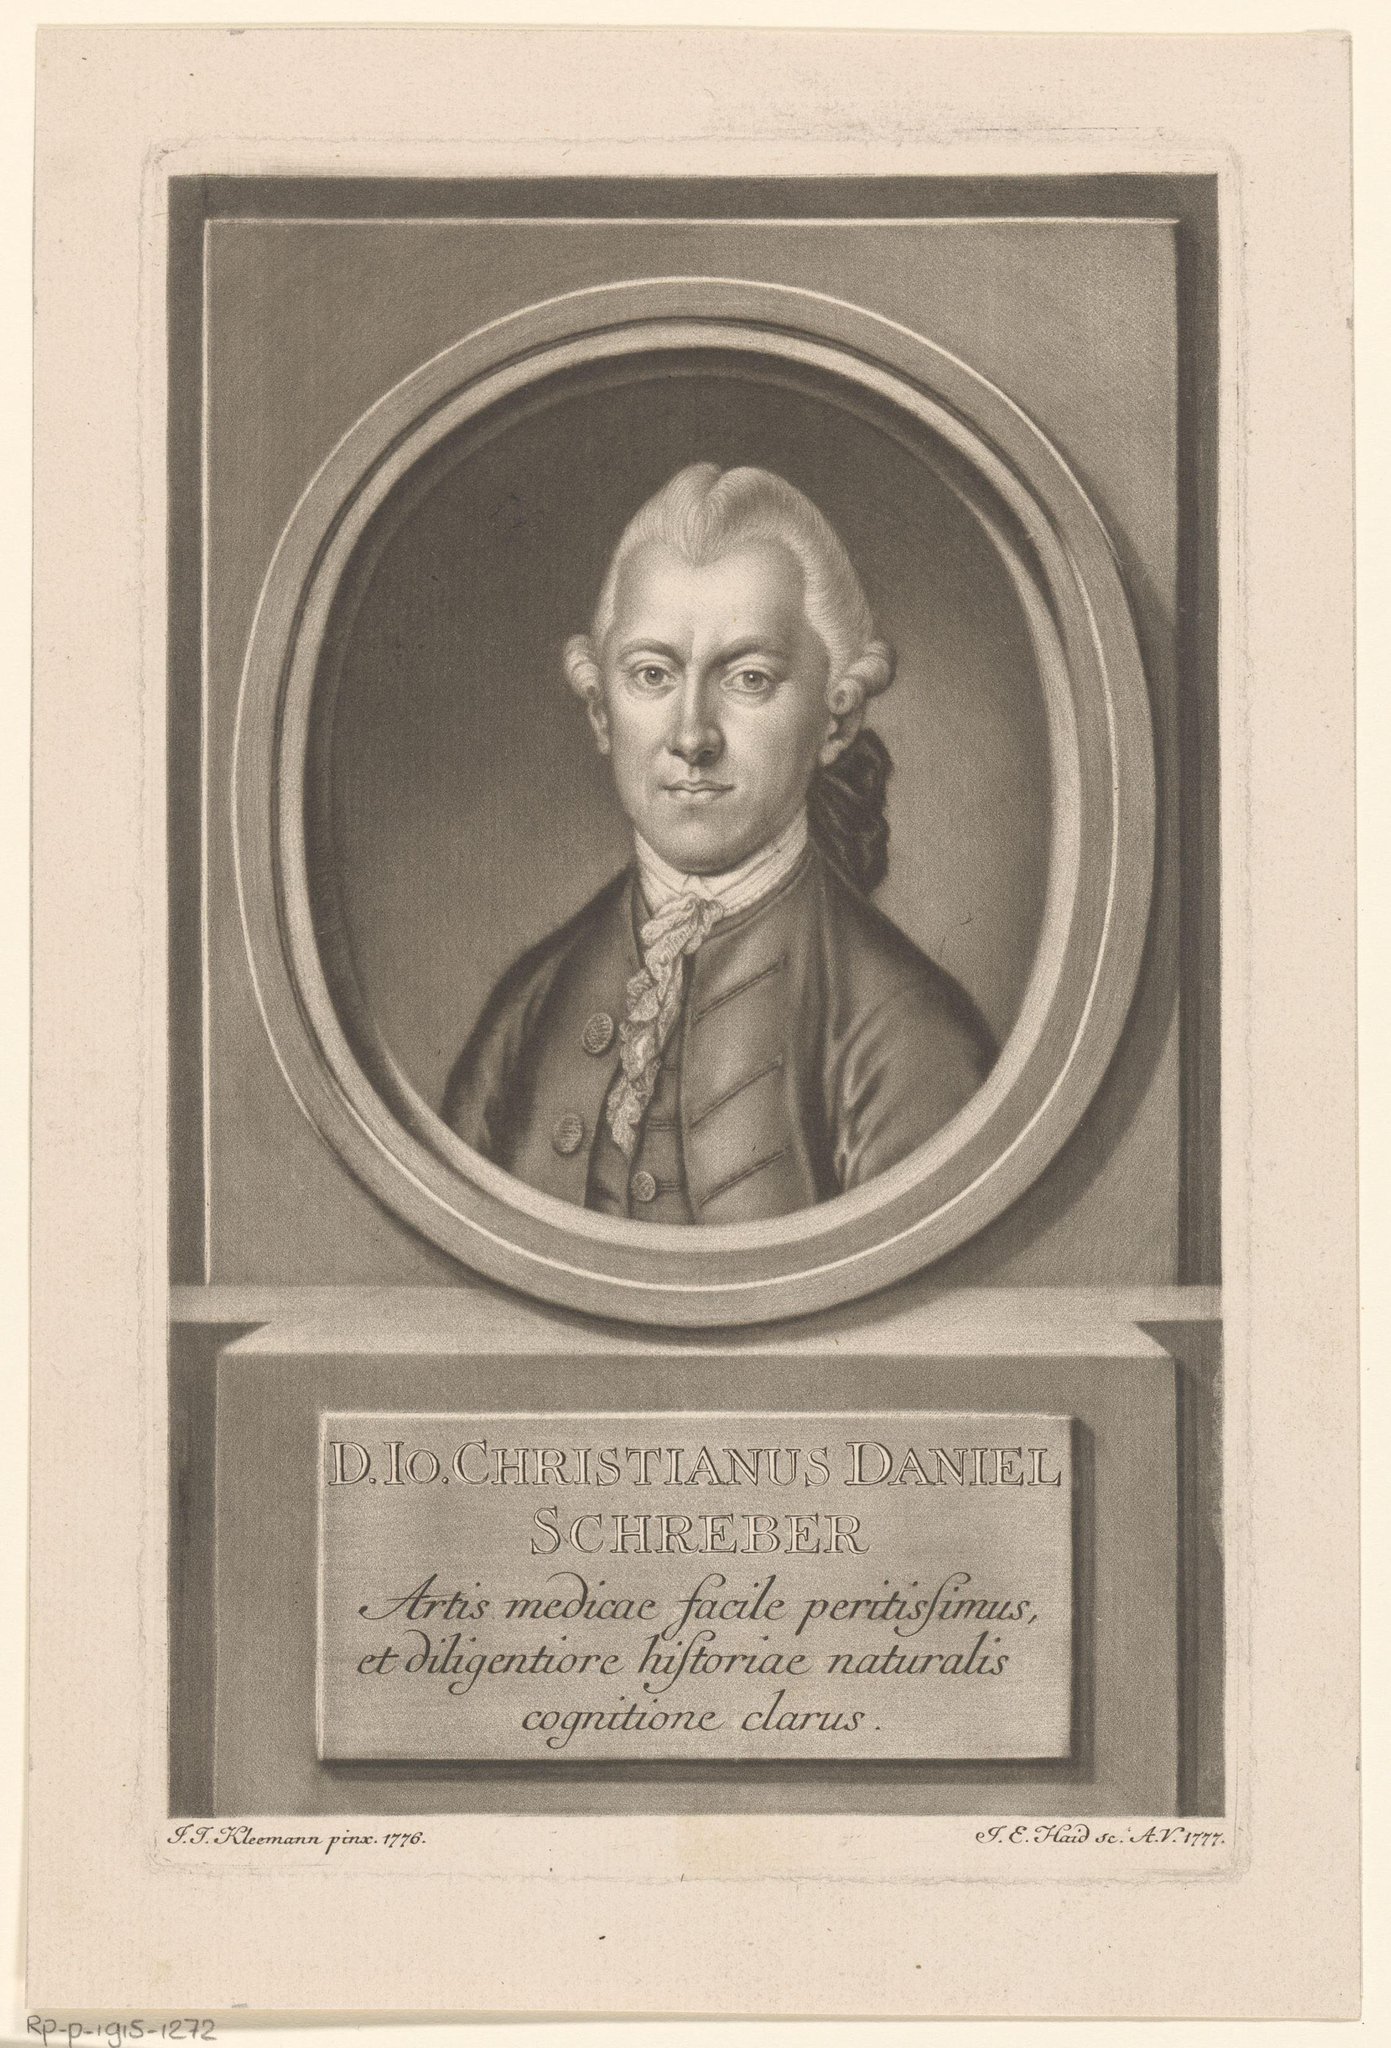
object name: print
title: Portret van Johann Christian Daniel Schreber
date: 1776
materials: paper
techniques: mezzotint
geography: augsburg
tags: historical persons, botany, zoology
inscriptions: collector's mark: Lugt 2228